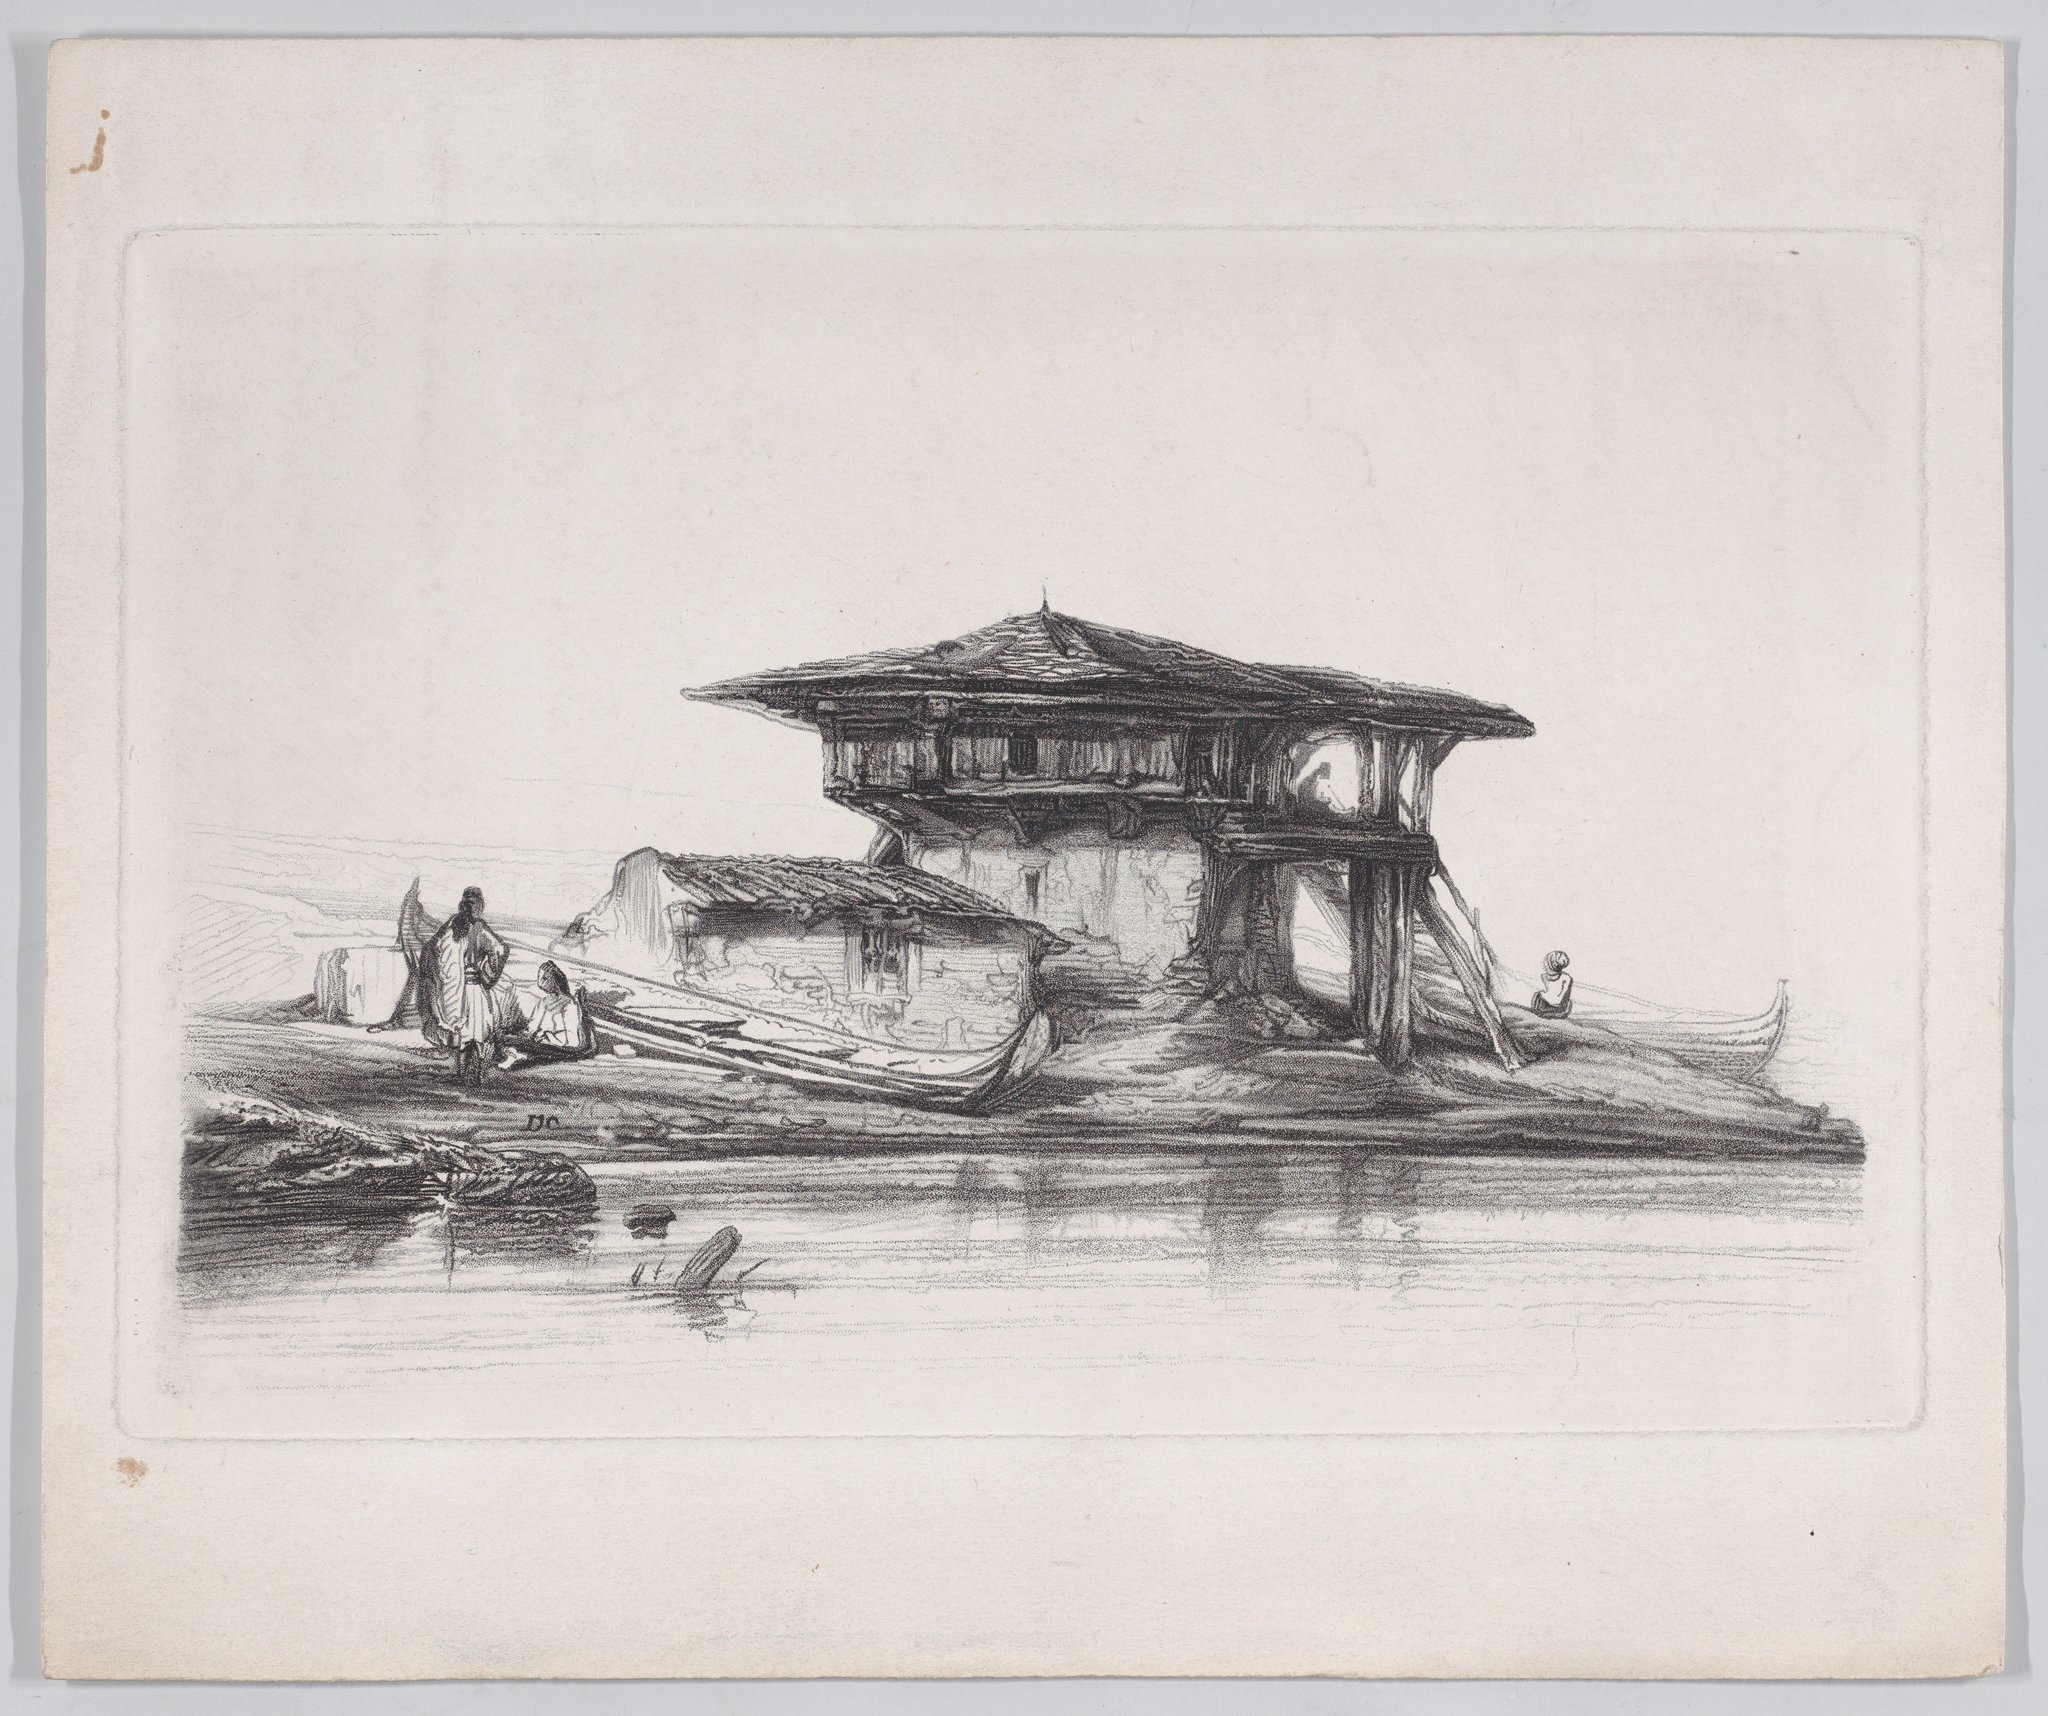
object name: print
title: A House in Smyrna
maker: alexandre-gabriel decamps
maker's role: artist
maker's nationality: french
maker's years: 1803-1860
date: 1839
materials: paper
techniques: roulette, etching